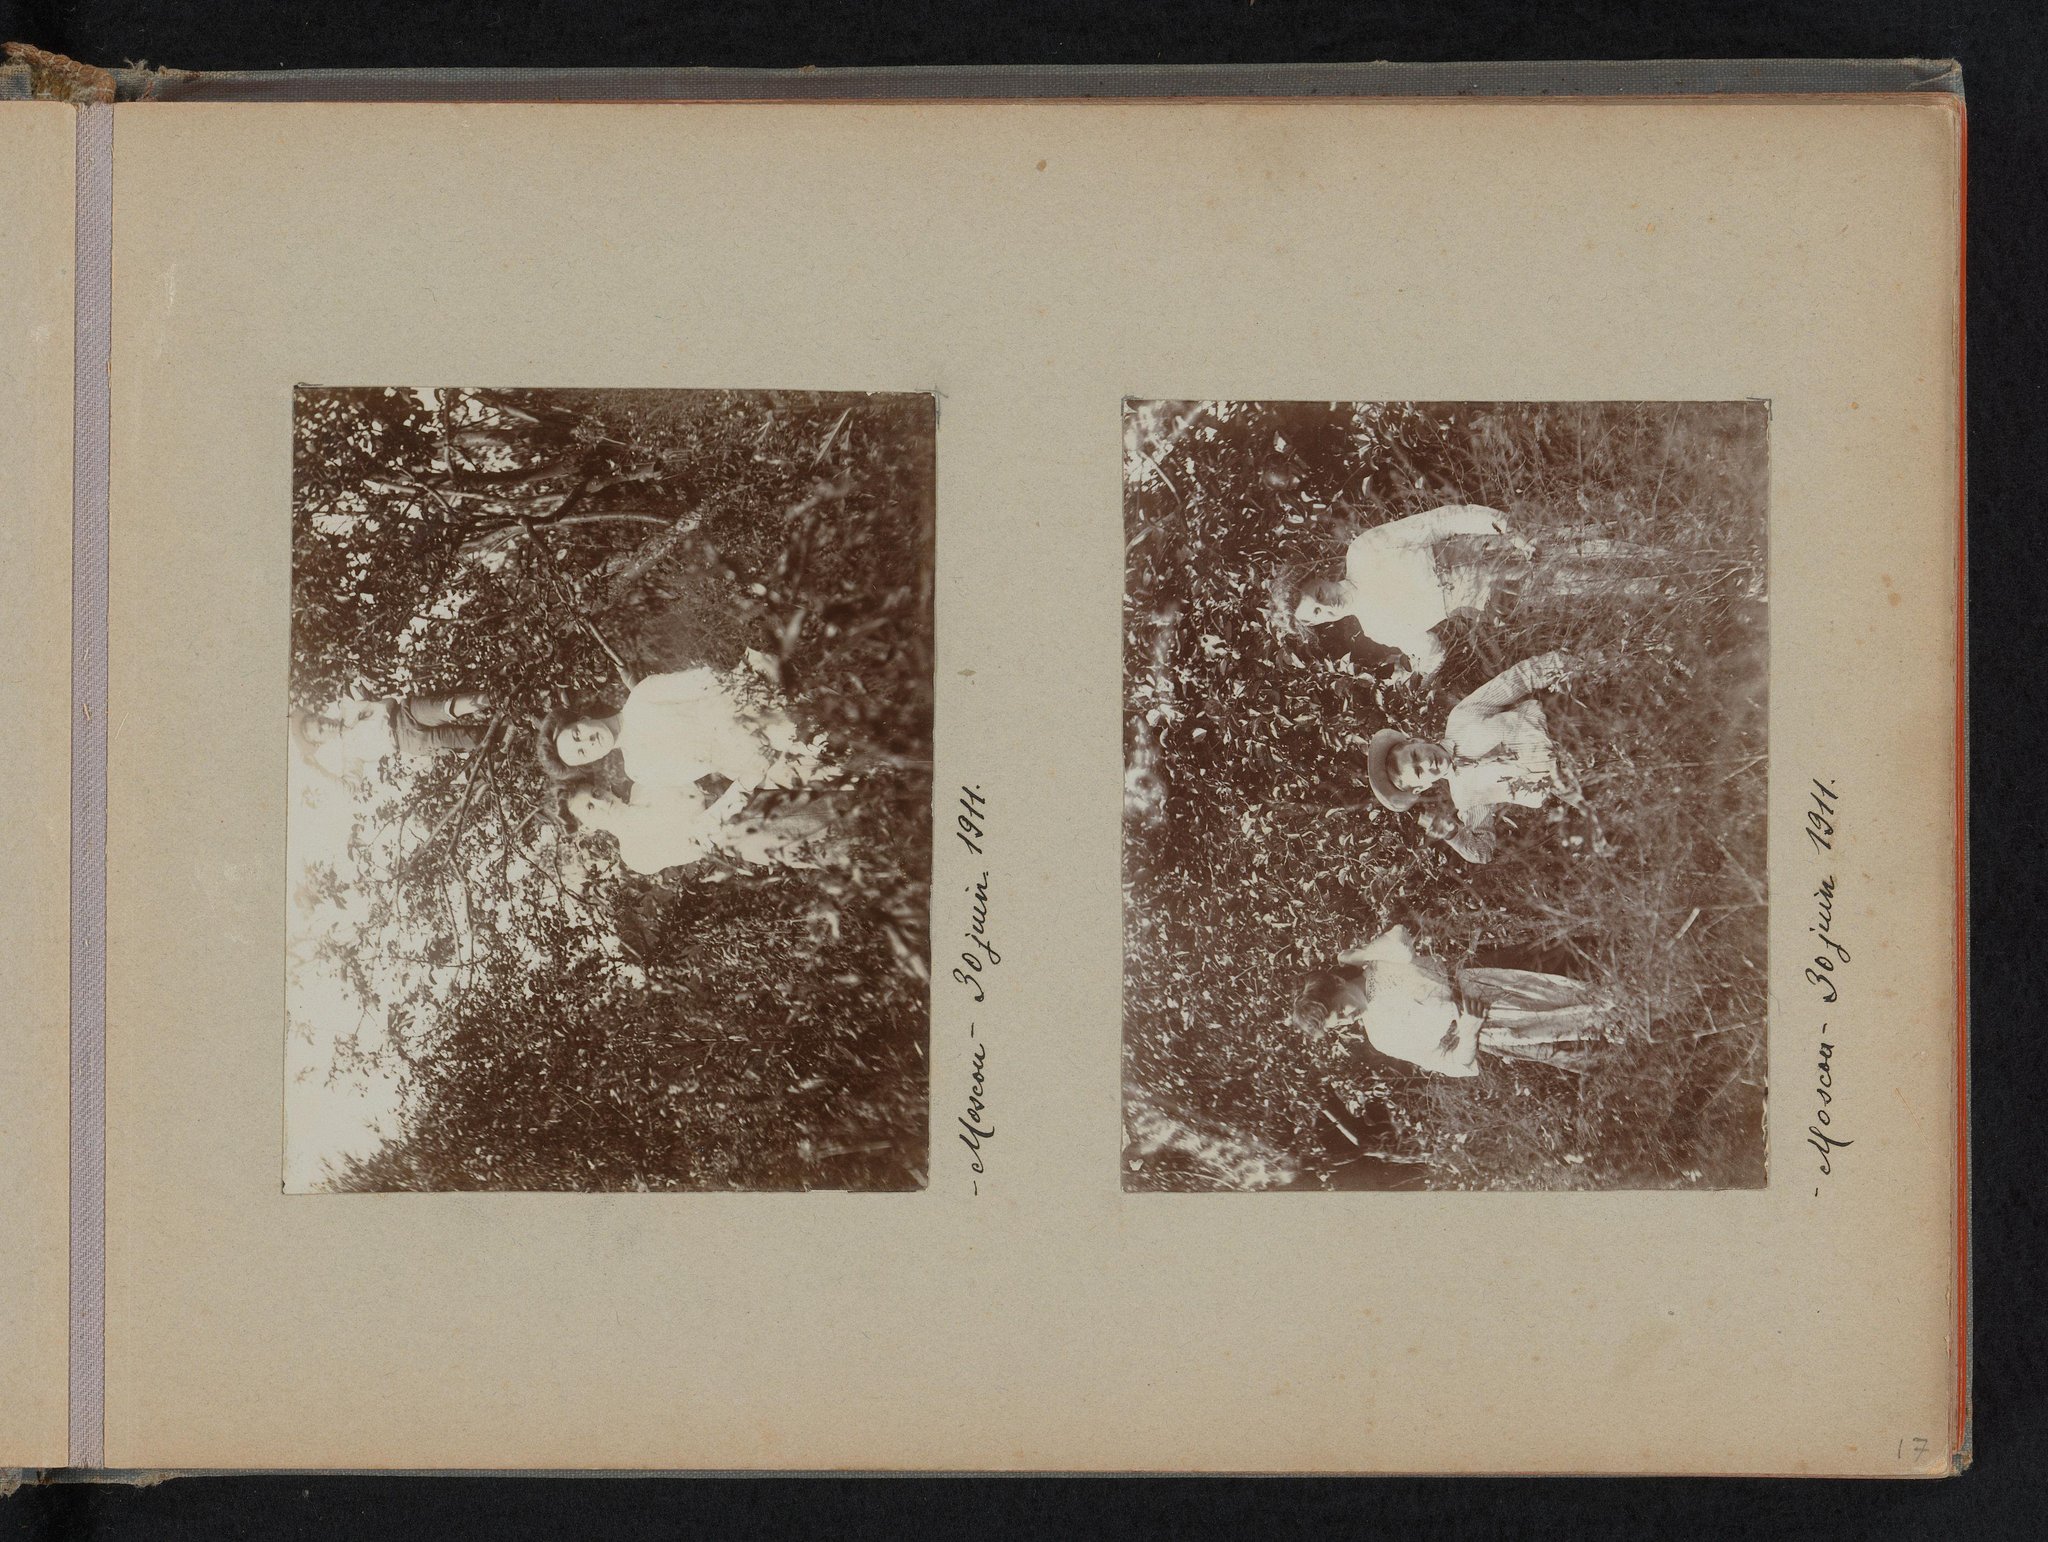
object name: photograph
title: Twee vrouwen en een jongen tussen struiken en bomen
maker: Anonymous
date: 1911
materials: paper, cardboard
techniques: collodion silver print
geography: moscow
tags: shrubs, historical persons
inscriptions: inscription: ‘- Moscou - 30 juin 1911.’, inscription: ‘- Moscou - 30 juin 1911.’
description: Deze foto's maken deel uit van een album.